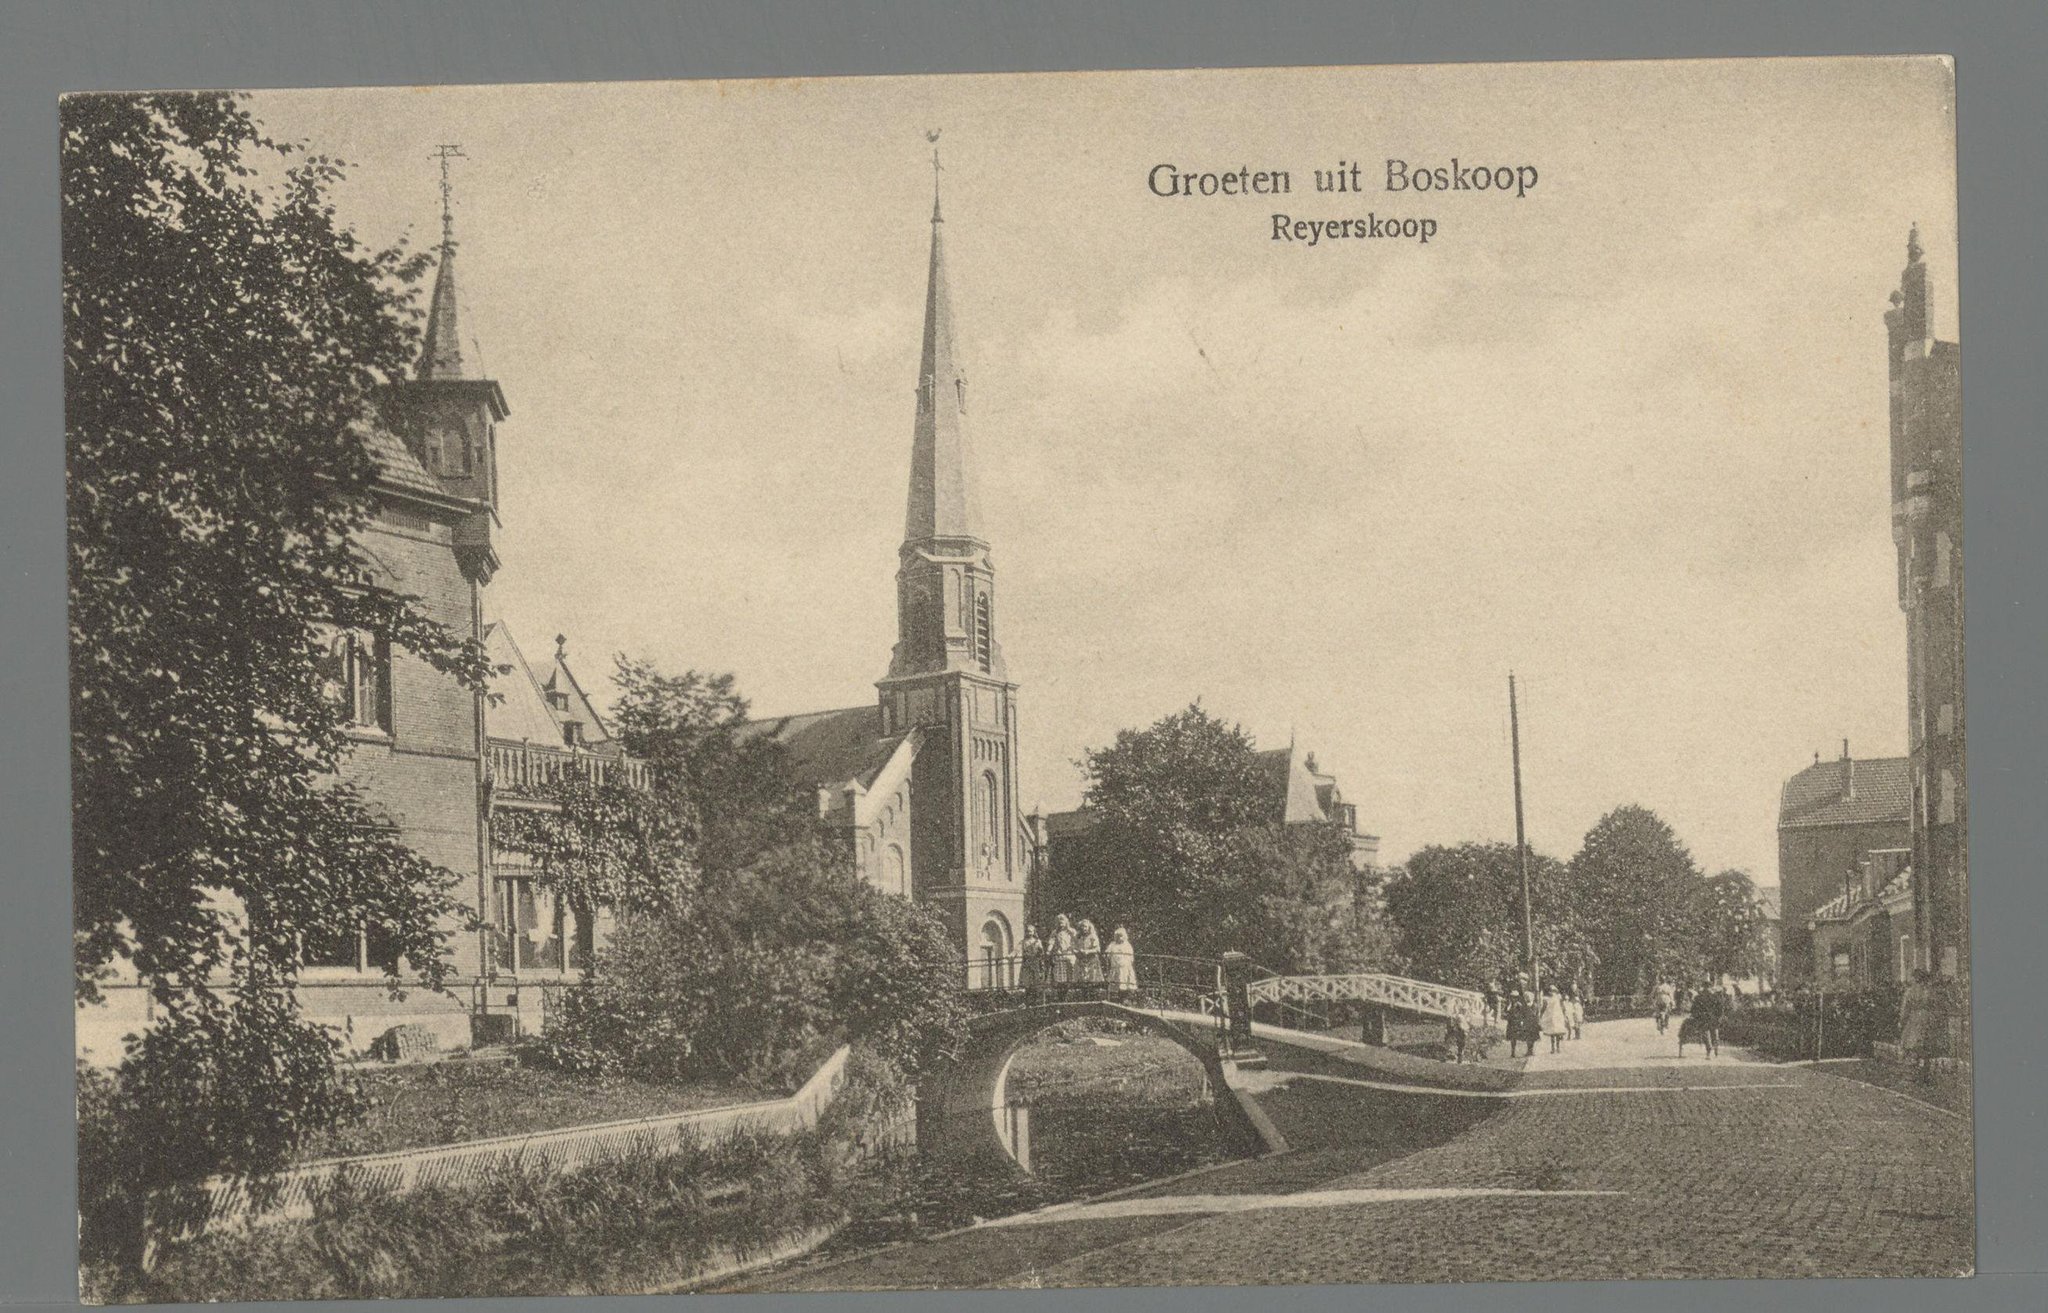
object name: photomechanical print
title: Groeten uit Boskoop. Reyerskoop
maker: Anonymous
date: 1918-1922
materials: cardboard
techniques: photograph, writing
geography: the hague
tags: city-view, and landscape with man-made constructions, church (exterior), bridge in city across river, canal, etc.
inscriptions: postage stamp